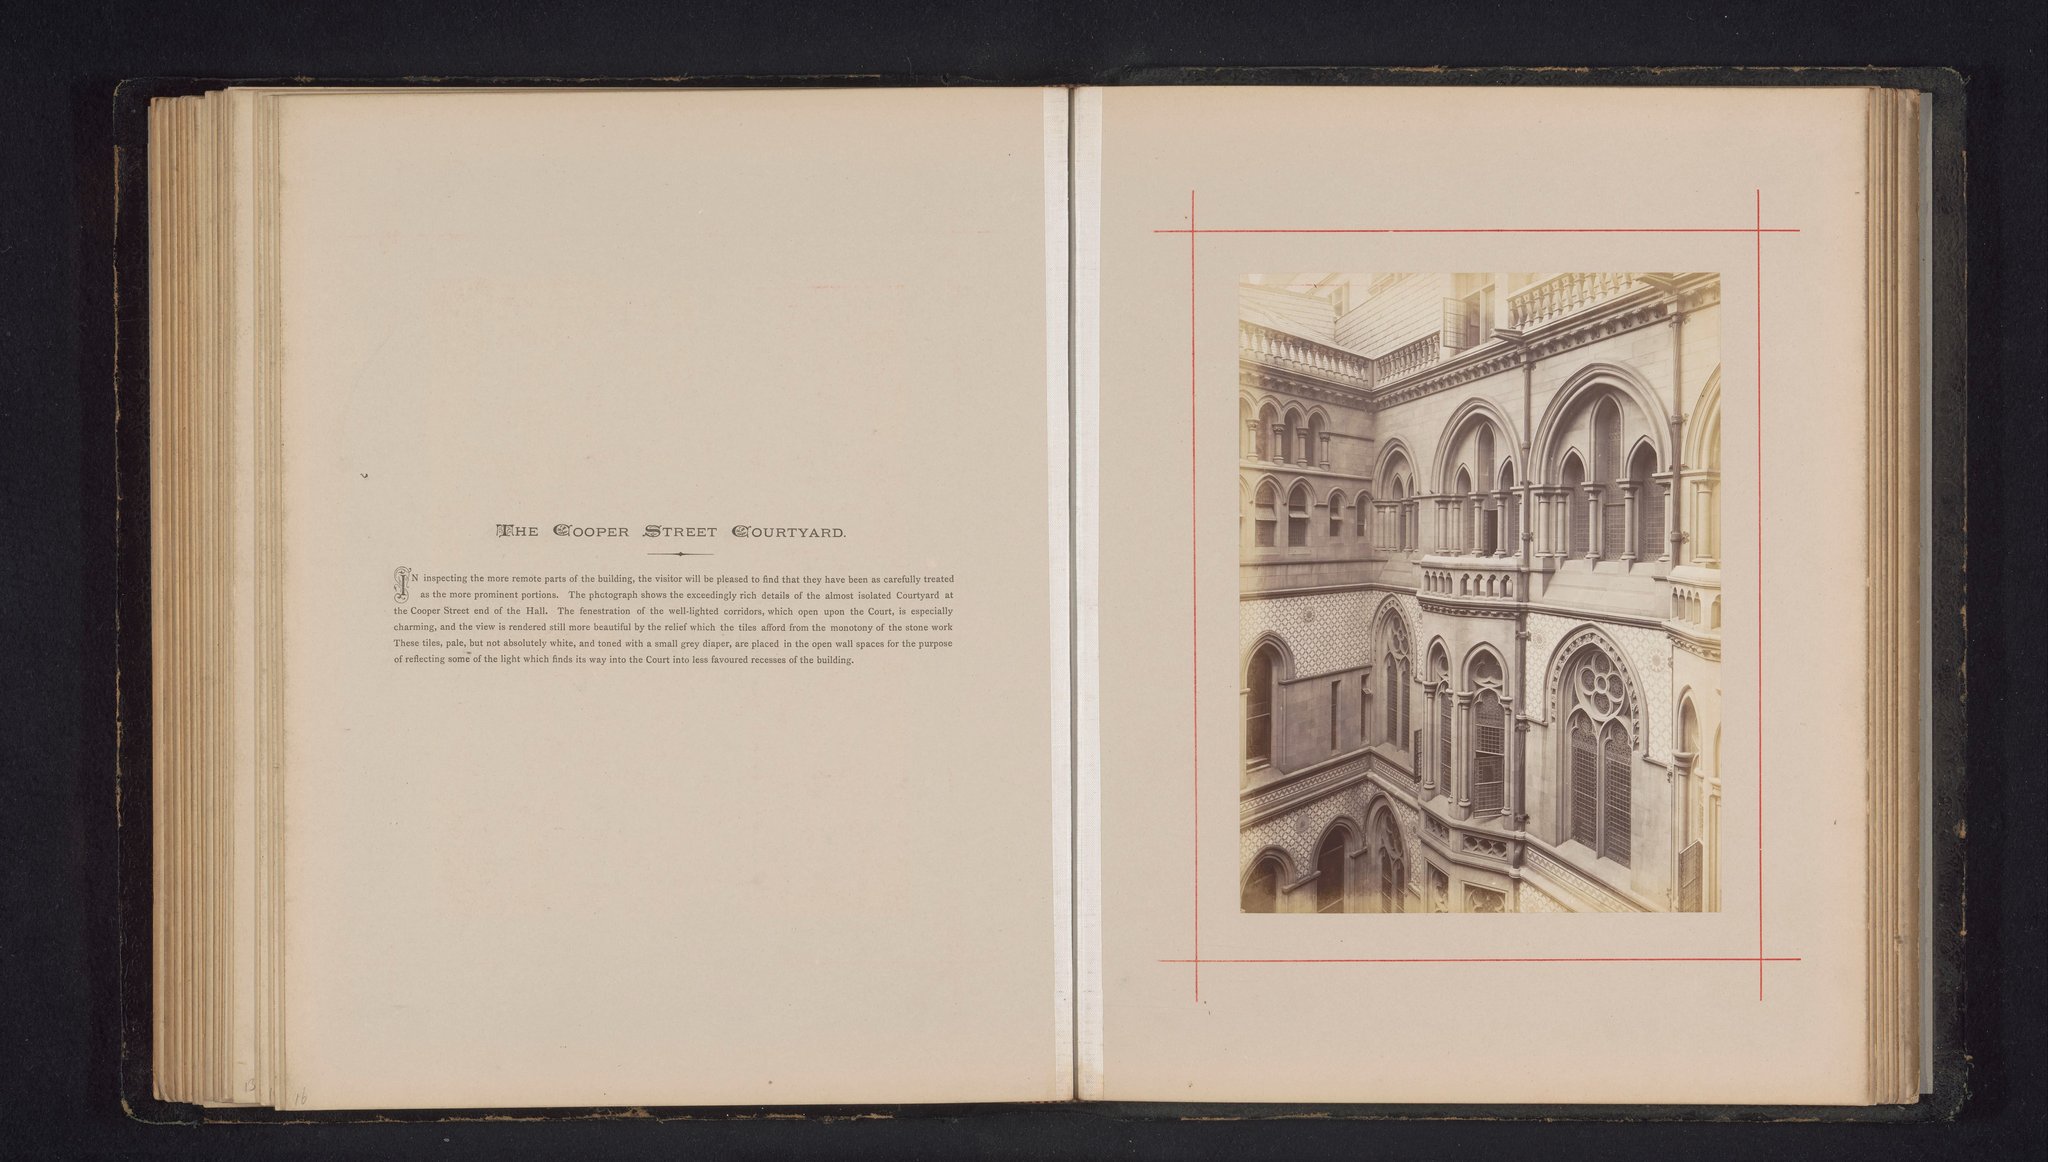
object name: page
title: Binnenhof van het Stadhuis van Manchester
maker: j. mcleod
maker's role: fotograaf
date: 1877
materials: photographic support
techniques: albumen print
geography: manchester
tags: townhall, courtyard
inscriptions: title: ‘The Cooper Street Courtyard’